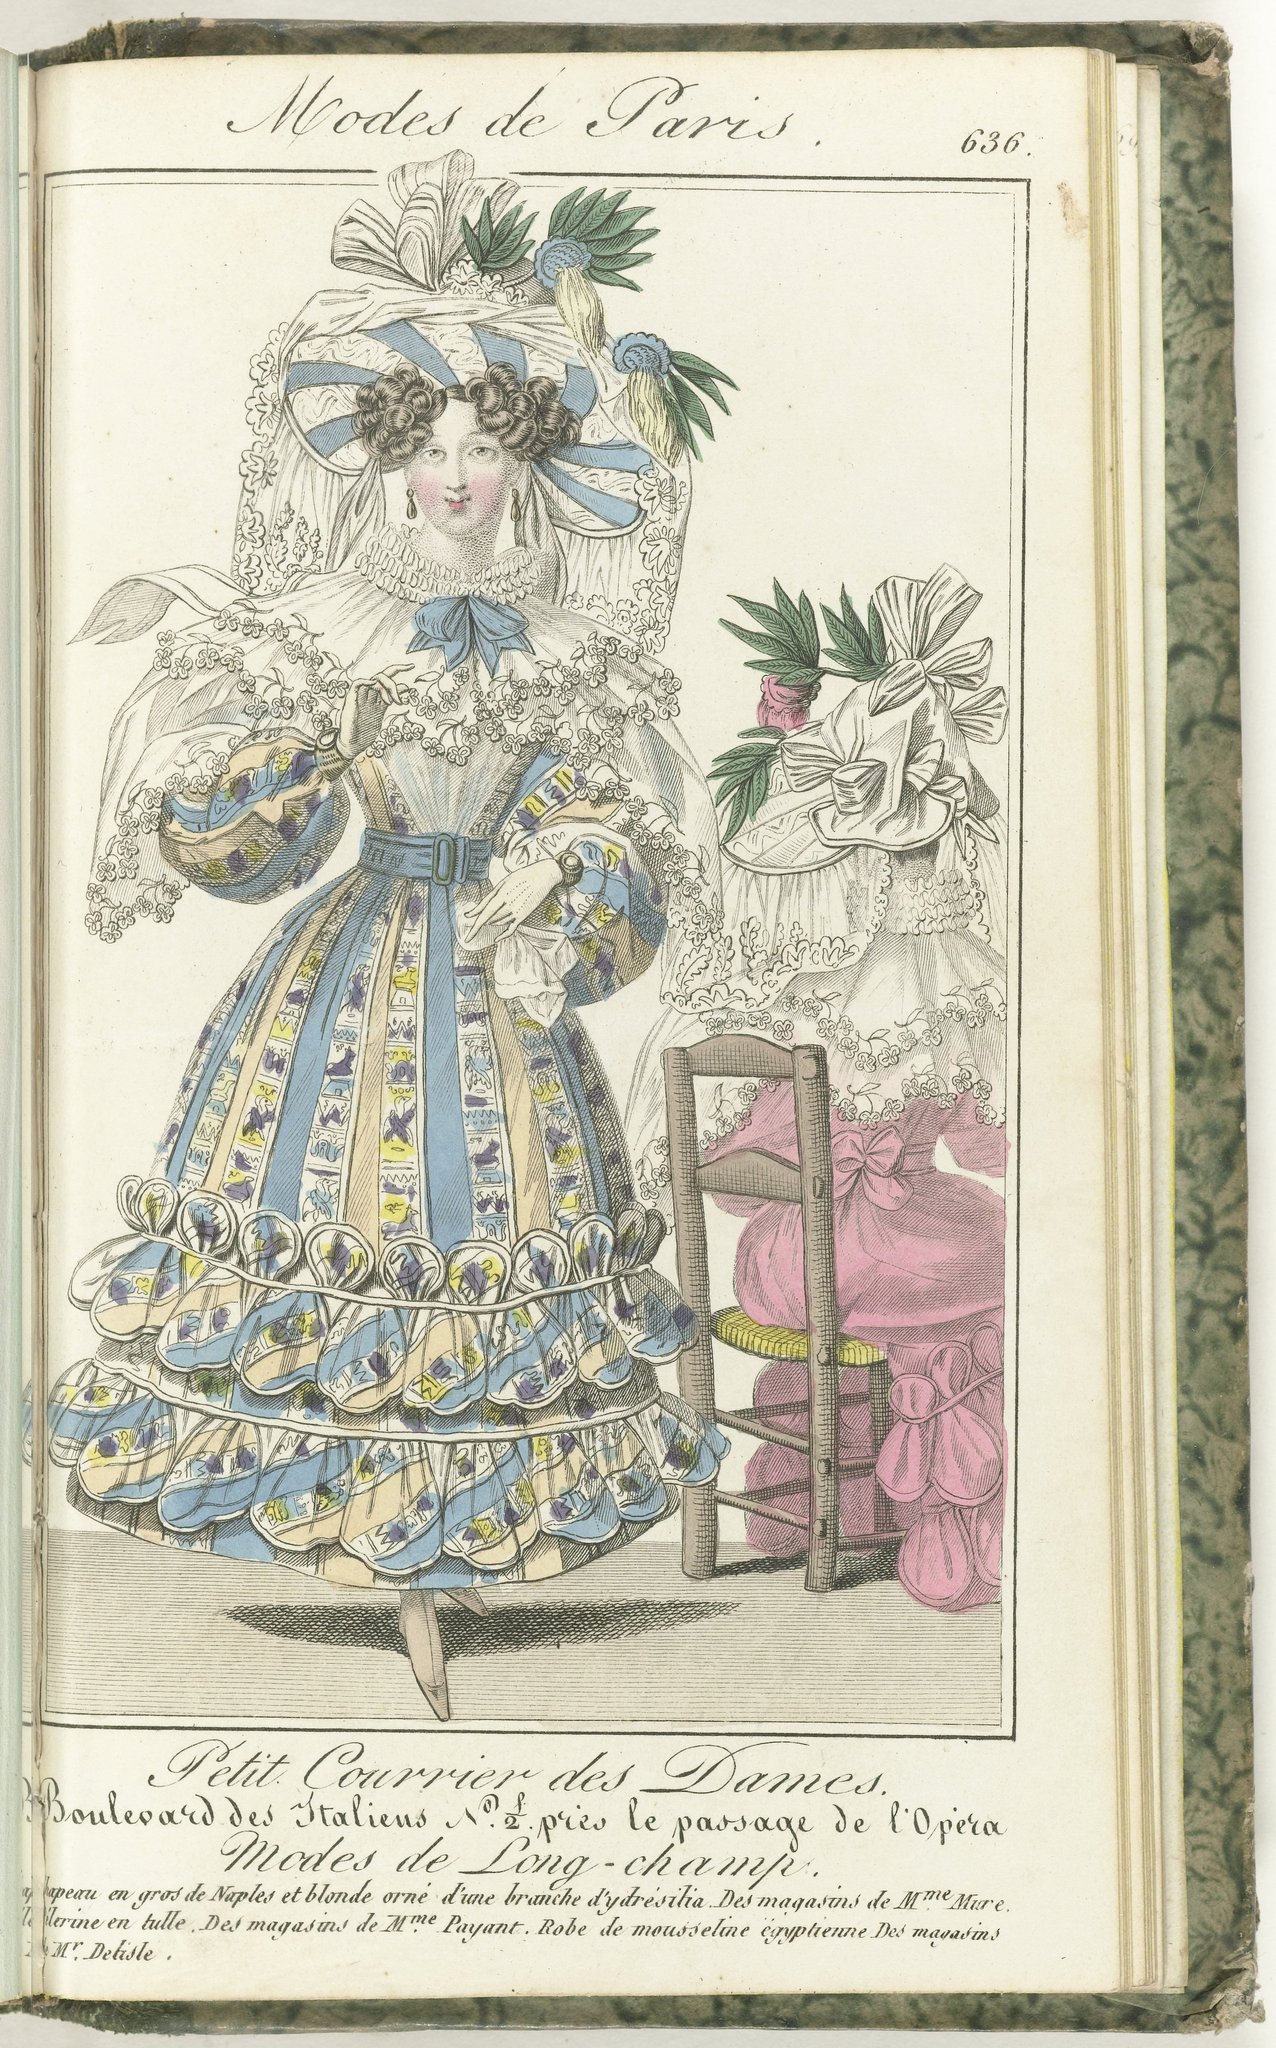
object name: fashion print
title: Petit Courrier des Dames, 5 mai 1829, No. 636: Modes de Long-champ...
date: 1829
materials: paper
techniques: engraving, hand coloring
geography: paris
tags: flowers, veil (+ women's clothes), clothing for the upper part of the body (pelerine) (+ women's clothes), lace (+ women's clothes), fashion plates, head-gear: hat (+ women's clothes), dress, gown (+ women's clothes)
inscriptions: title: ‘Petit Courrier des Dames.’, caption: ‘Modes de Long-champ. / Chapeau en gros de Naples et blonde orné d'une branche d'ydrésilia. Des magasins de M.me Mure. Pélerine en tulle. Des magasins de M.me Payant. Robe de mousseline égyptienne Des magasins de M.r Delisle.’, address: ‘Boulevard des Italiens No.2 près le passage de l'Opèra.’, title: ‘Modes de Paris.’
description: 'Modes de Long-champ.' Staande vrouw in een japon van 'mousseline egyptienne' met strepenmotief, uit de winkels van Delisle. Pelerine van tule, uit de winkels van Payant. Op het hoofd een hoed van 'gros de Naples' en Blonde (kloskant) versierd met een tak, uit de winkels van Mure. Zittende figuur, op de rug gezien, in eenzelfde japon. Prent uit het modetijdschrift Petit Courrier des Dames (1821-1868). Ingebonden (met enkele pag. Le Journal des Dames et des Modes). 15 Januari 1827 t/m 20 maart 1830. Incompleet.